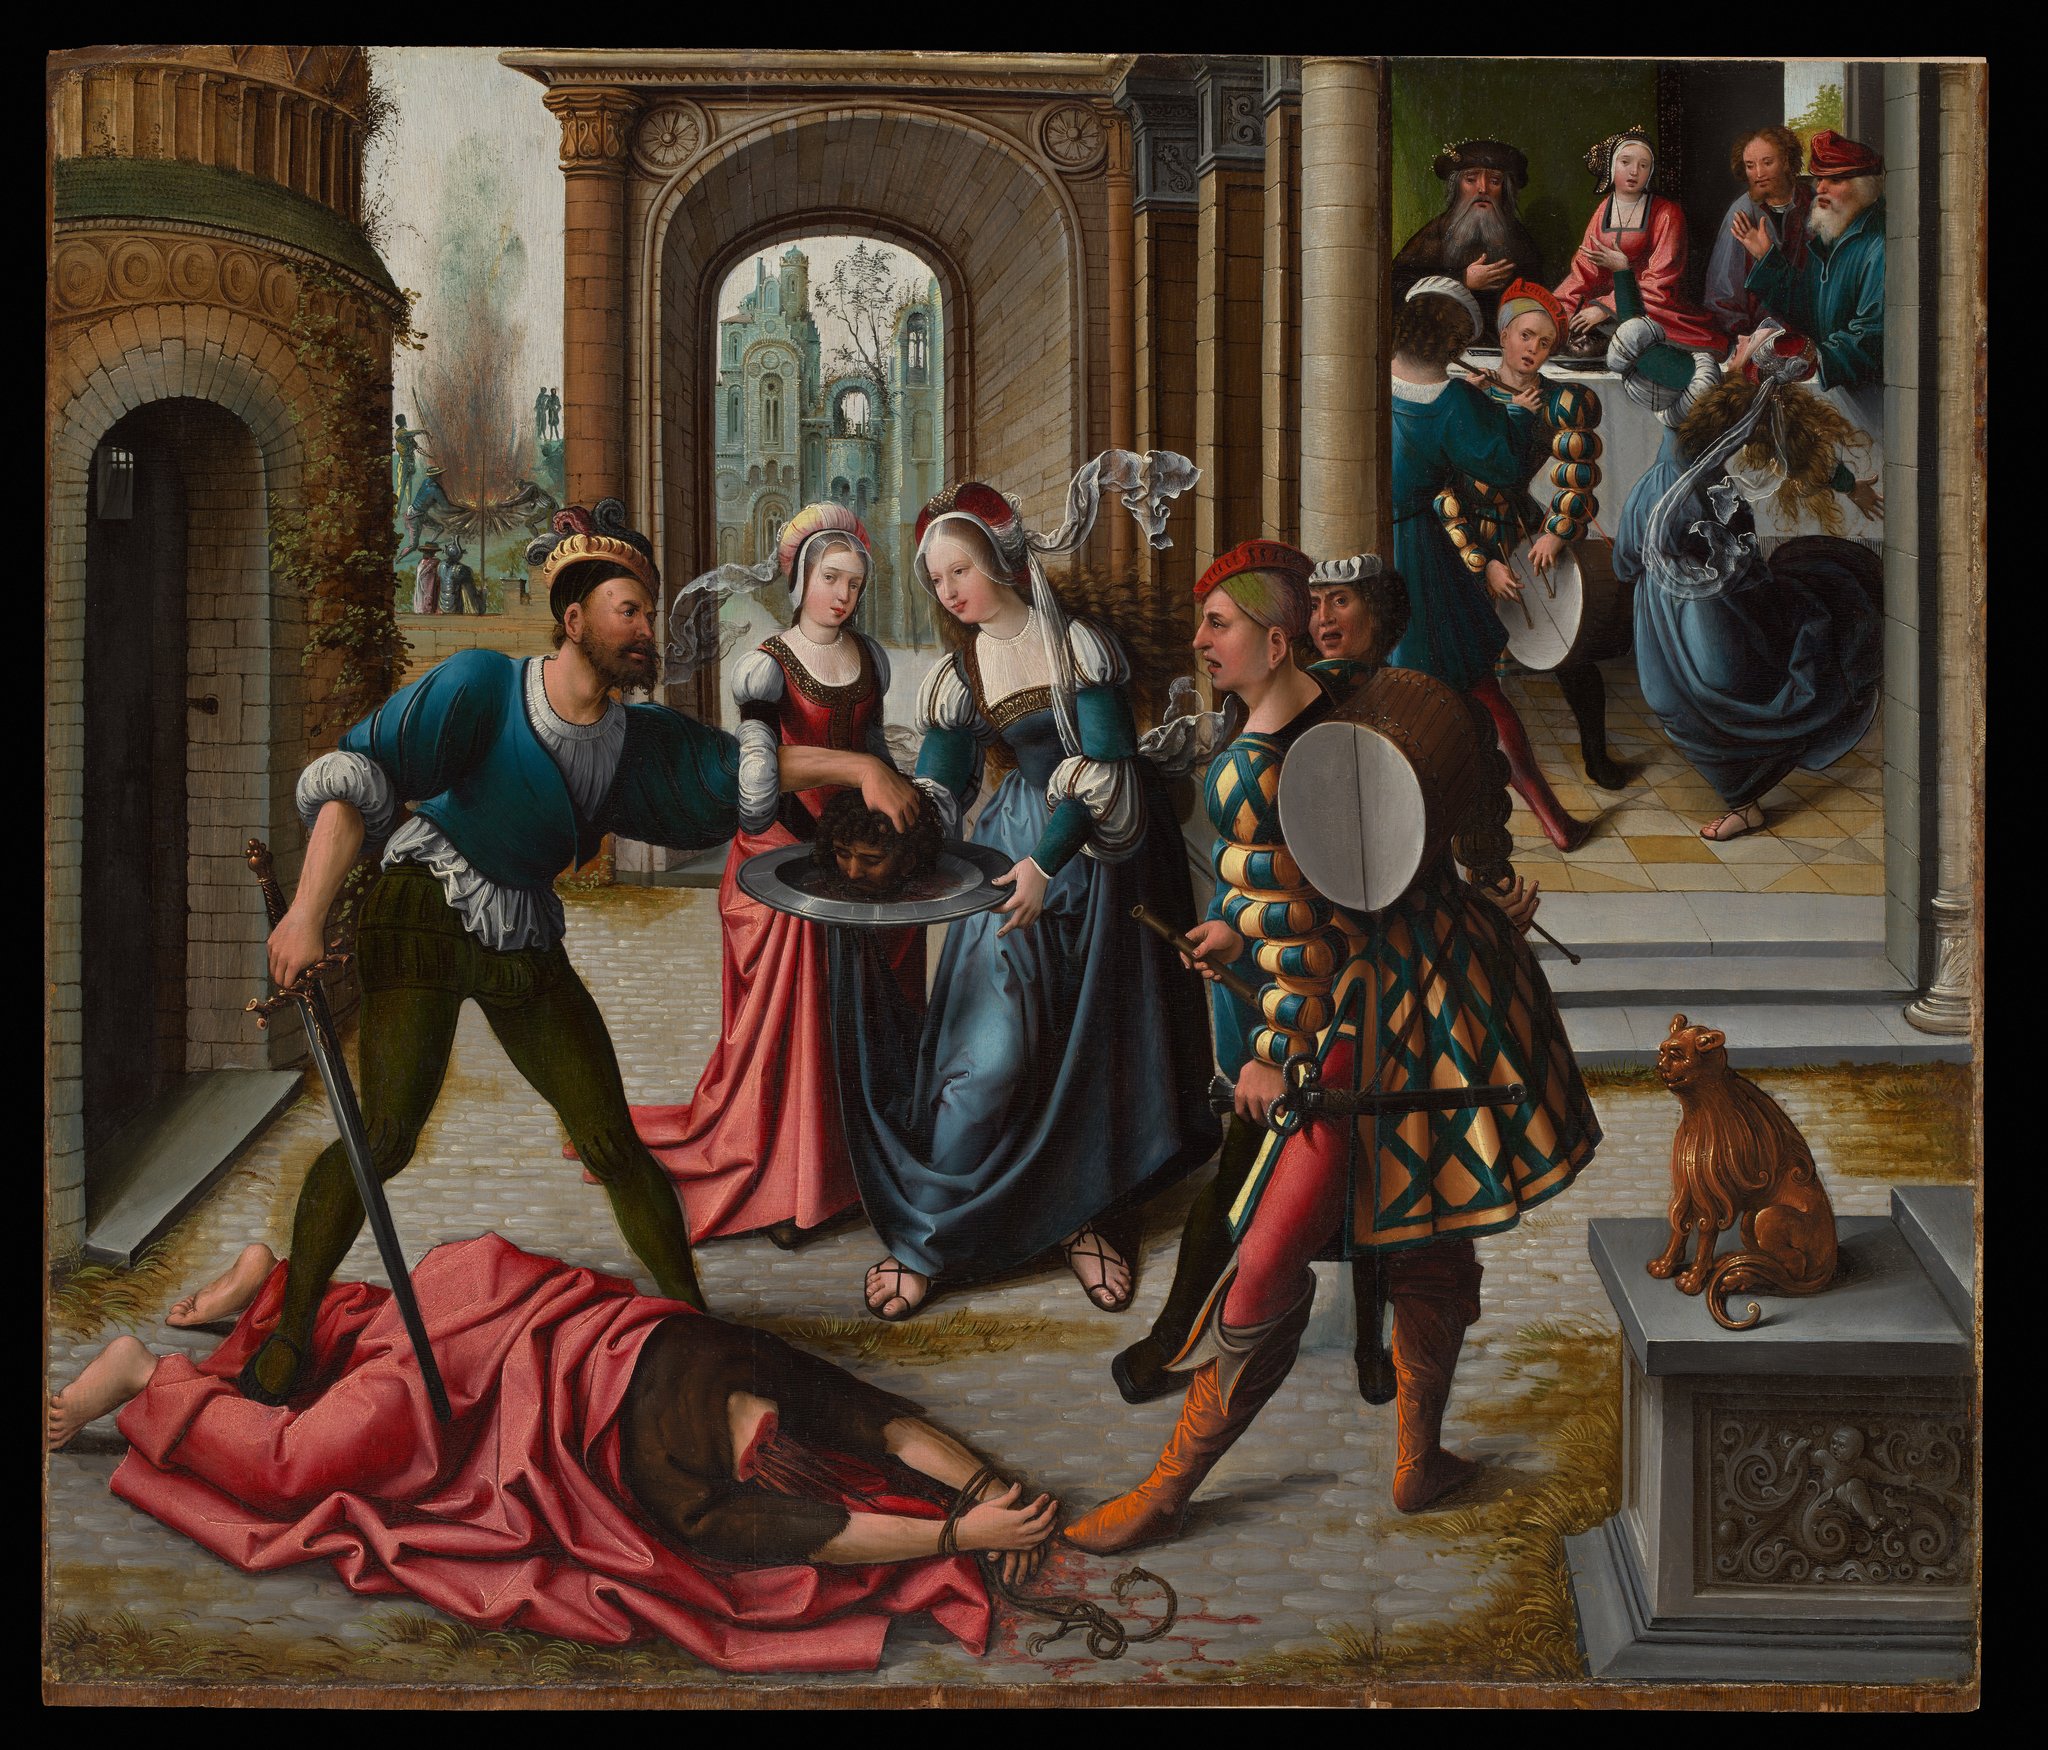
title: The Martyrdom of Saint John the Baptist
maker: bernard van orley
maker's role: artist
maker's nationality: netherlandish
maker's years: 1492-1542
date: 1514-1515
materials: oil, wood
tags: men,women,saint john the baptist,beds,salome